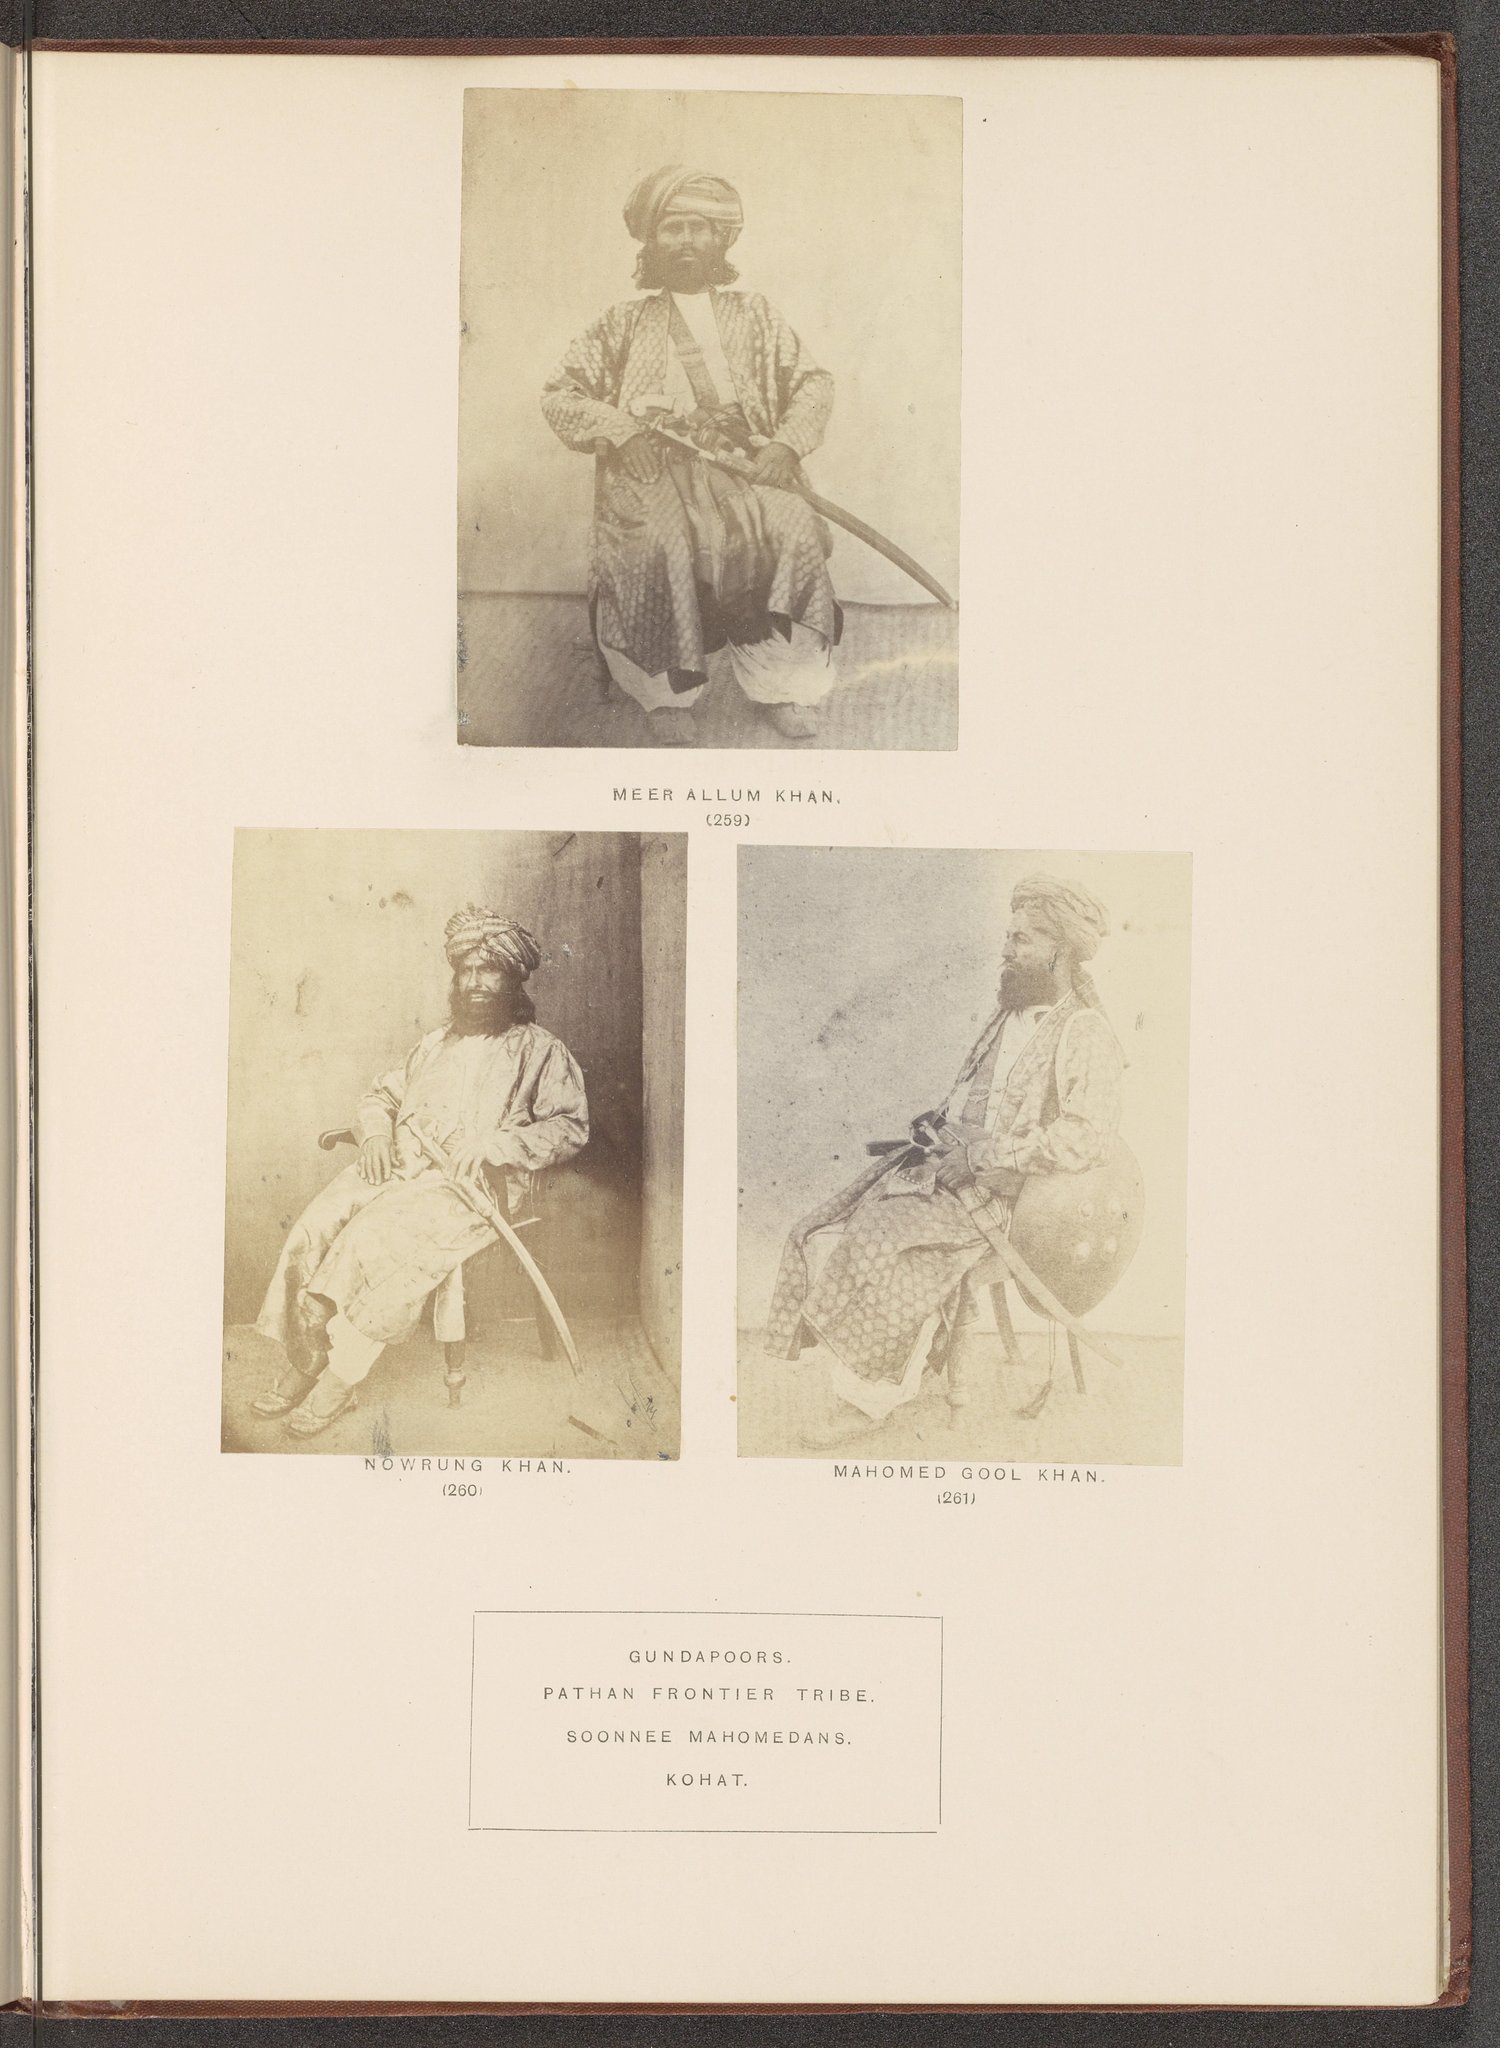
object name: photograph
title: Portraits of Meer Allum Khan, Nowrung Khan and Mahomed Gool Khan, three chiefs from the Gandapur tribe of Kohat, Khyber Pakhtunkhwa, Pakistan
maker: Anonymous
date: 1862-1872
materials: photographic support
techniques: albumen print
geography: kohat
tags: hacking and thrusting weapons (with name), head-gear: turban, ruler, sovereign, human races; peoples; nationalities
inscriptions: number: ‘(259),/ (260), (261)’, inscription: ‘MEER ALLUM KHAN./ NOWRUNG KHAN. MAHOMED GOOL KHAN./ GUNDAPOORS./ PATHAN FRONTIER TRIBE./ SOONNEE MAHOMEDANS./ KOHAT.’